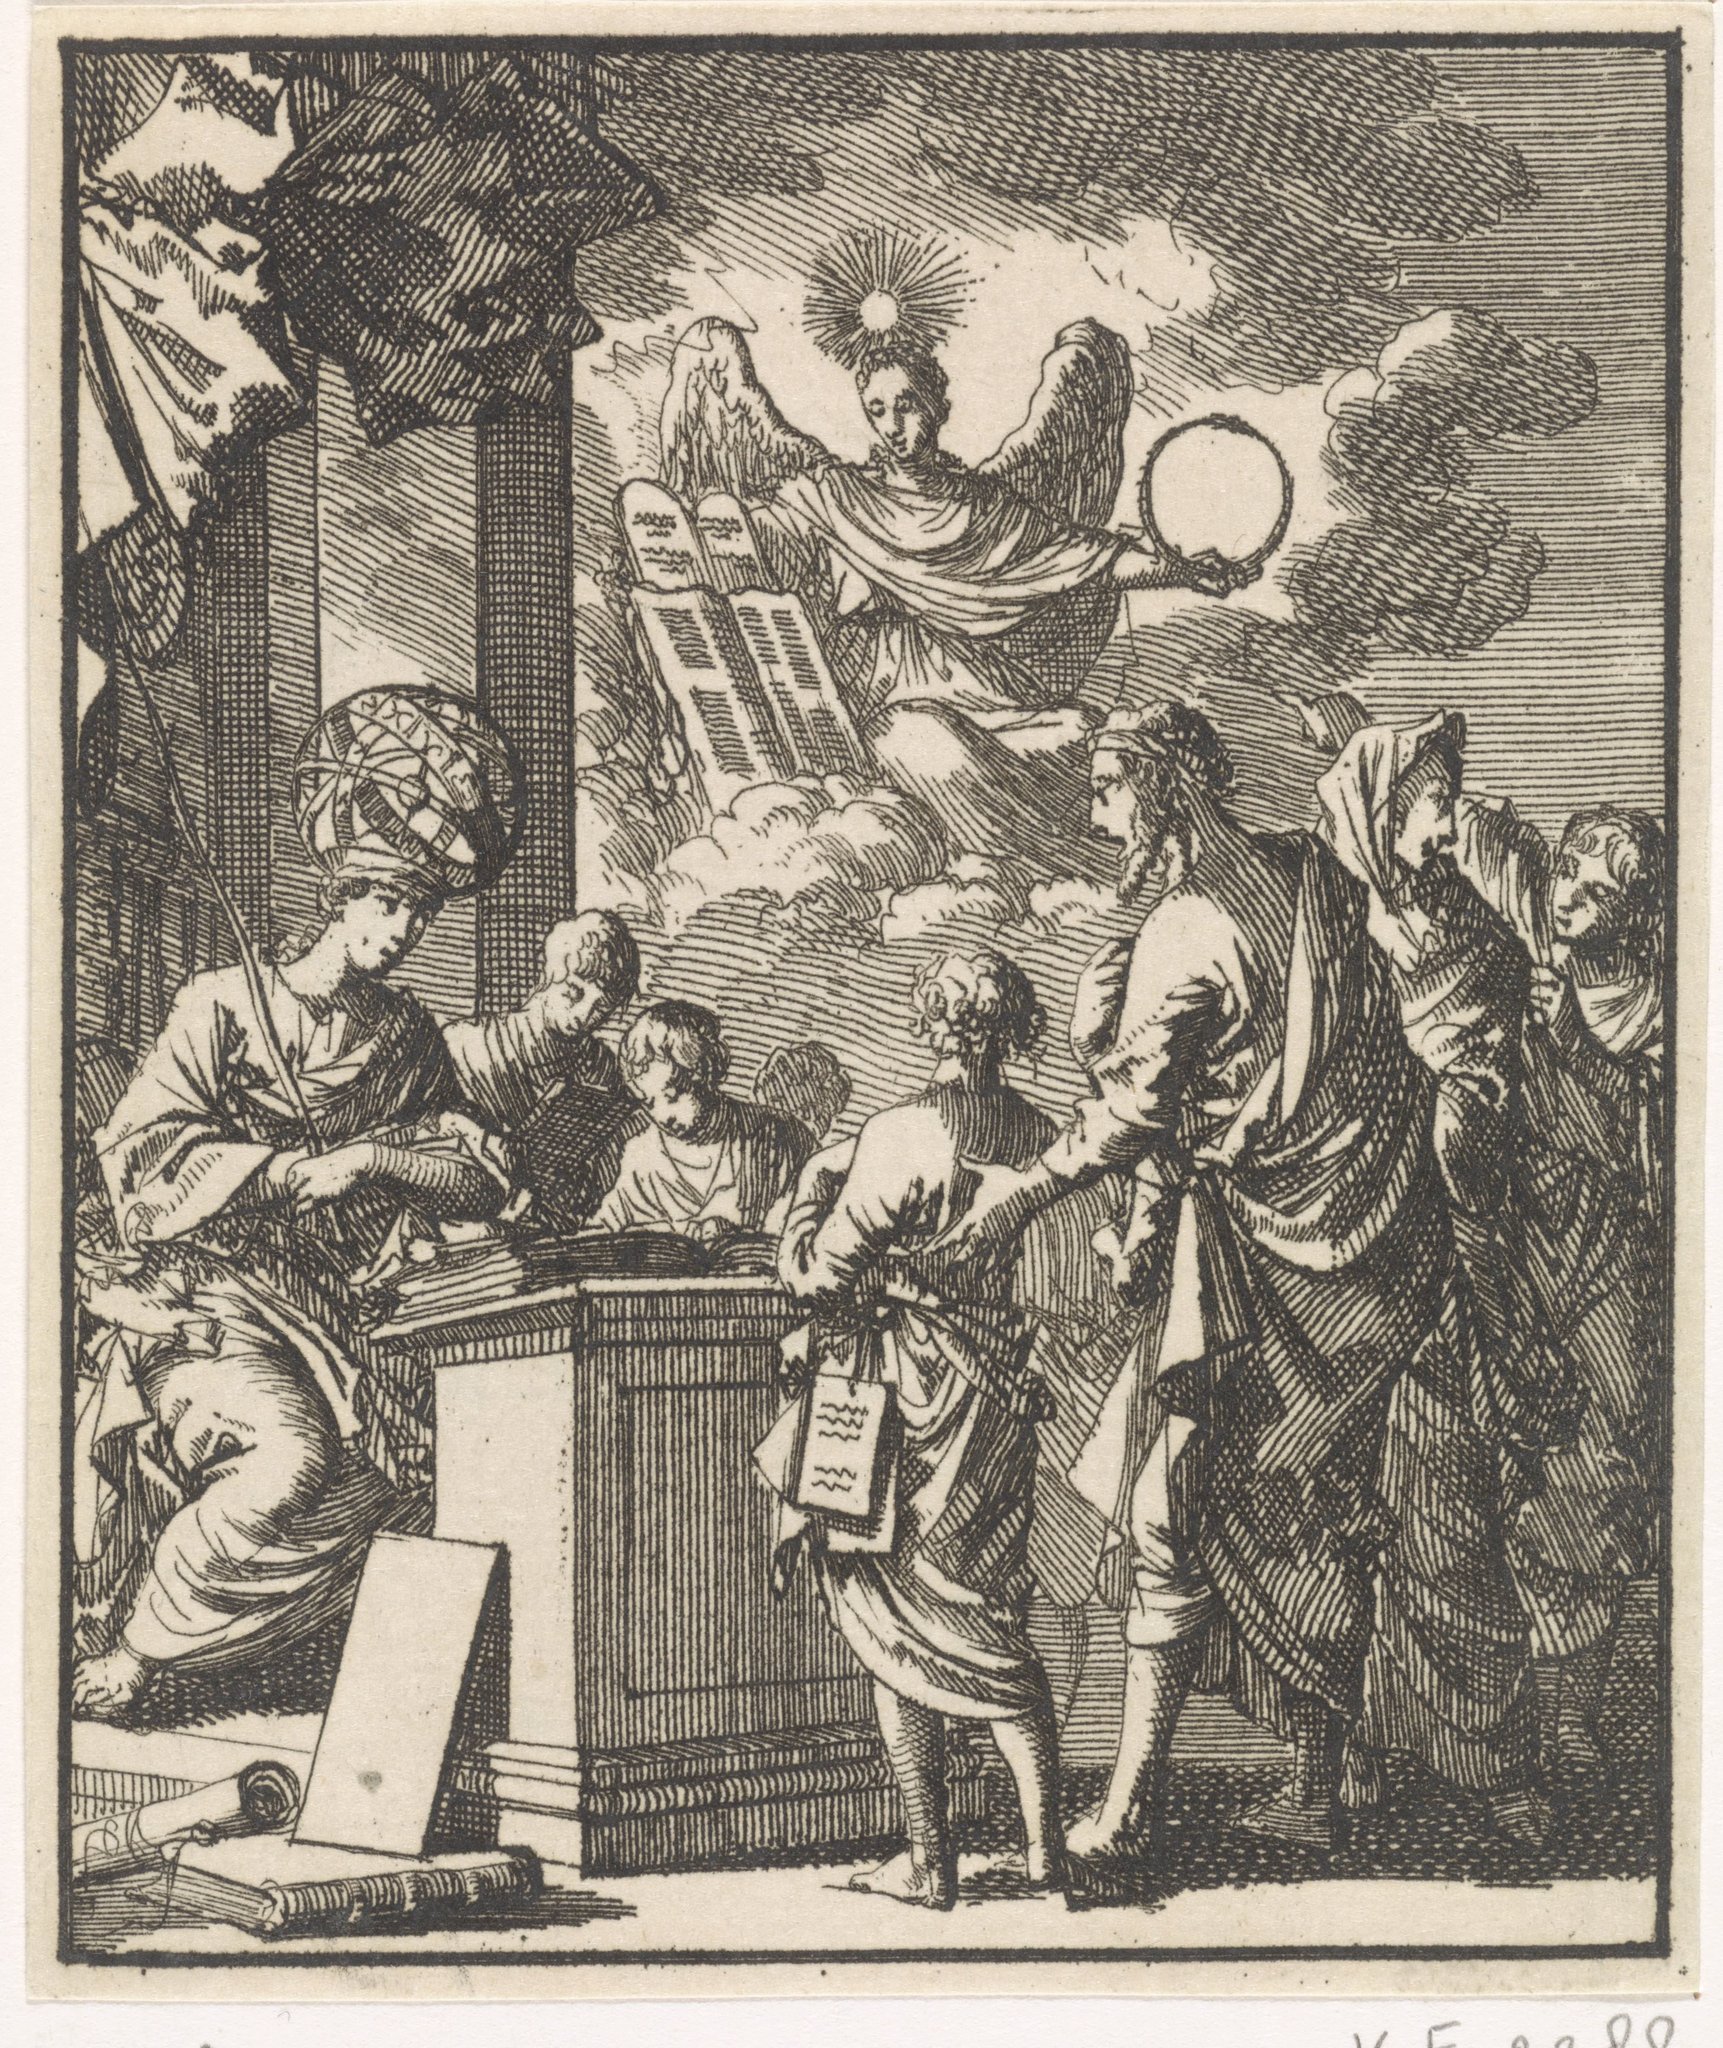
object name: book illustration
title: Wetenschap en Goddelijke Wijsheid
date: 1699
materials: paper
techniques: etching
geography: amsterdam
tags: symbolic representations, allegories and emblems ~ science, 'scientia'; 'scienza', 'studio' (ripa), eternity, 'aeternitas'; 'eternità','eternità o perpetuità' (ripa), serpent ouroboros, education, 'sapientia', wisdom; 'sapienza divina' (ripa) ~ one of the seven gifts of the holy ghost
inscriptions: collector's mark: Lugt 2228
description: Op de voorgrond de personificatie Wetenschap, met een armillarium op haar hoofd. Ze geeft les aan enkele jongeren, terwijl twee ouders een andere jongen bij haar brengen. In de lucht openbaart zich Goddelijke Wijsheid, een gevleugelde vrouw met de tien geboden en de worm ouroboros in haar handen.